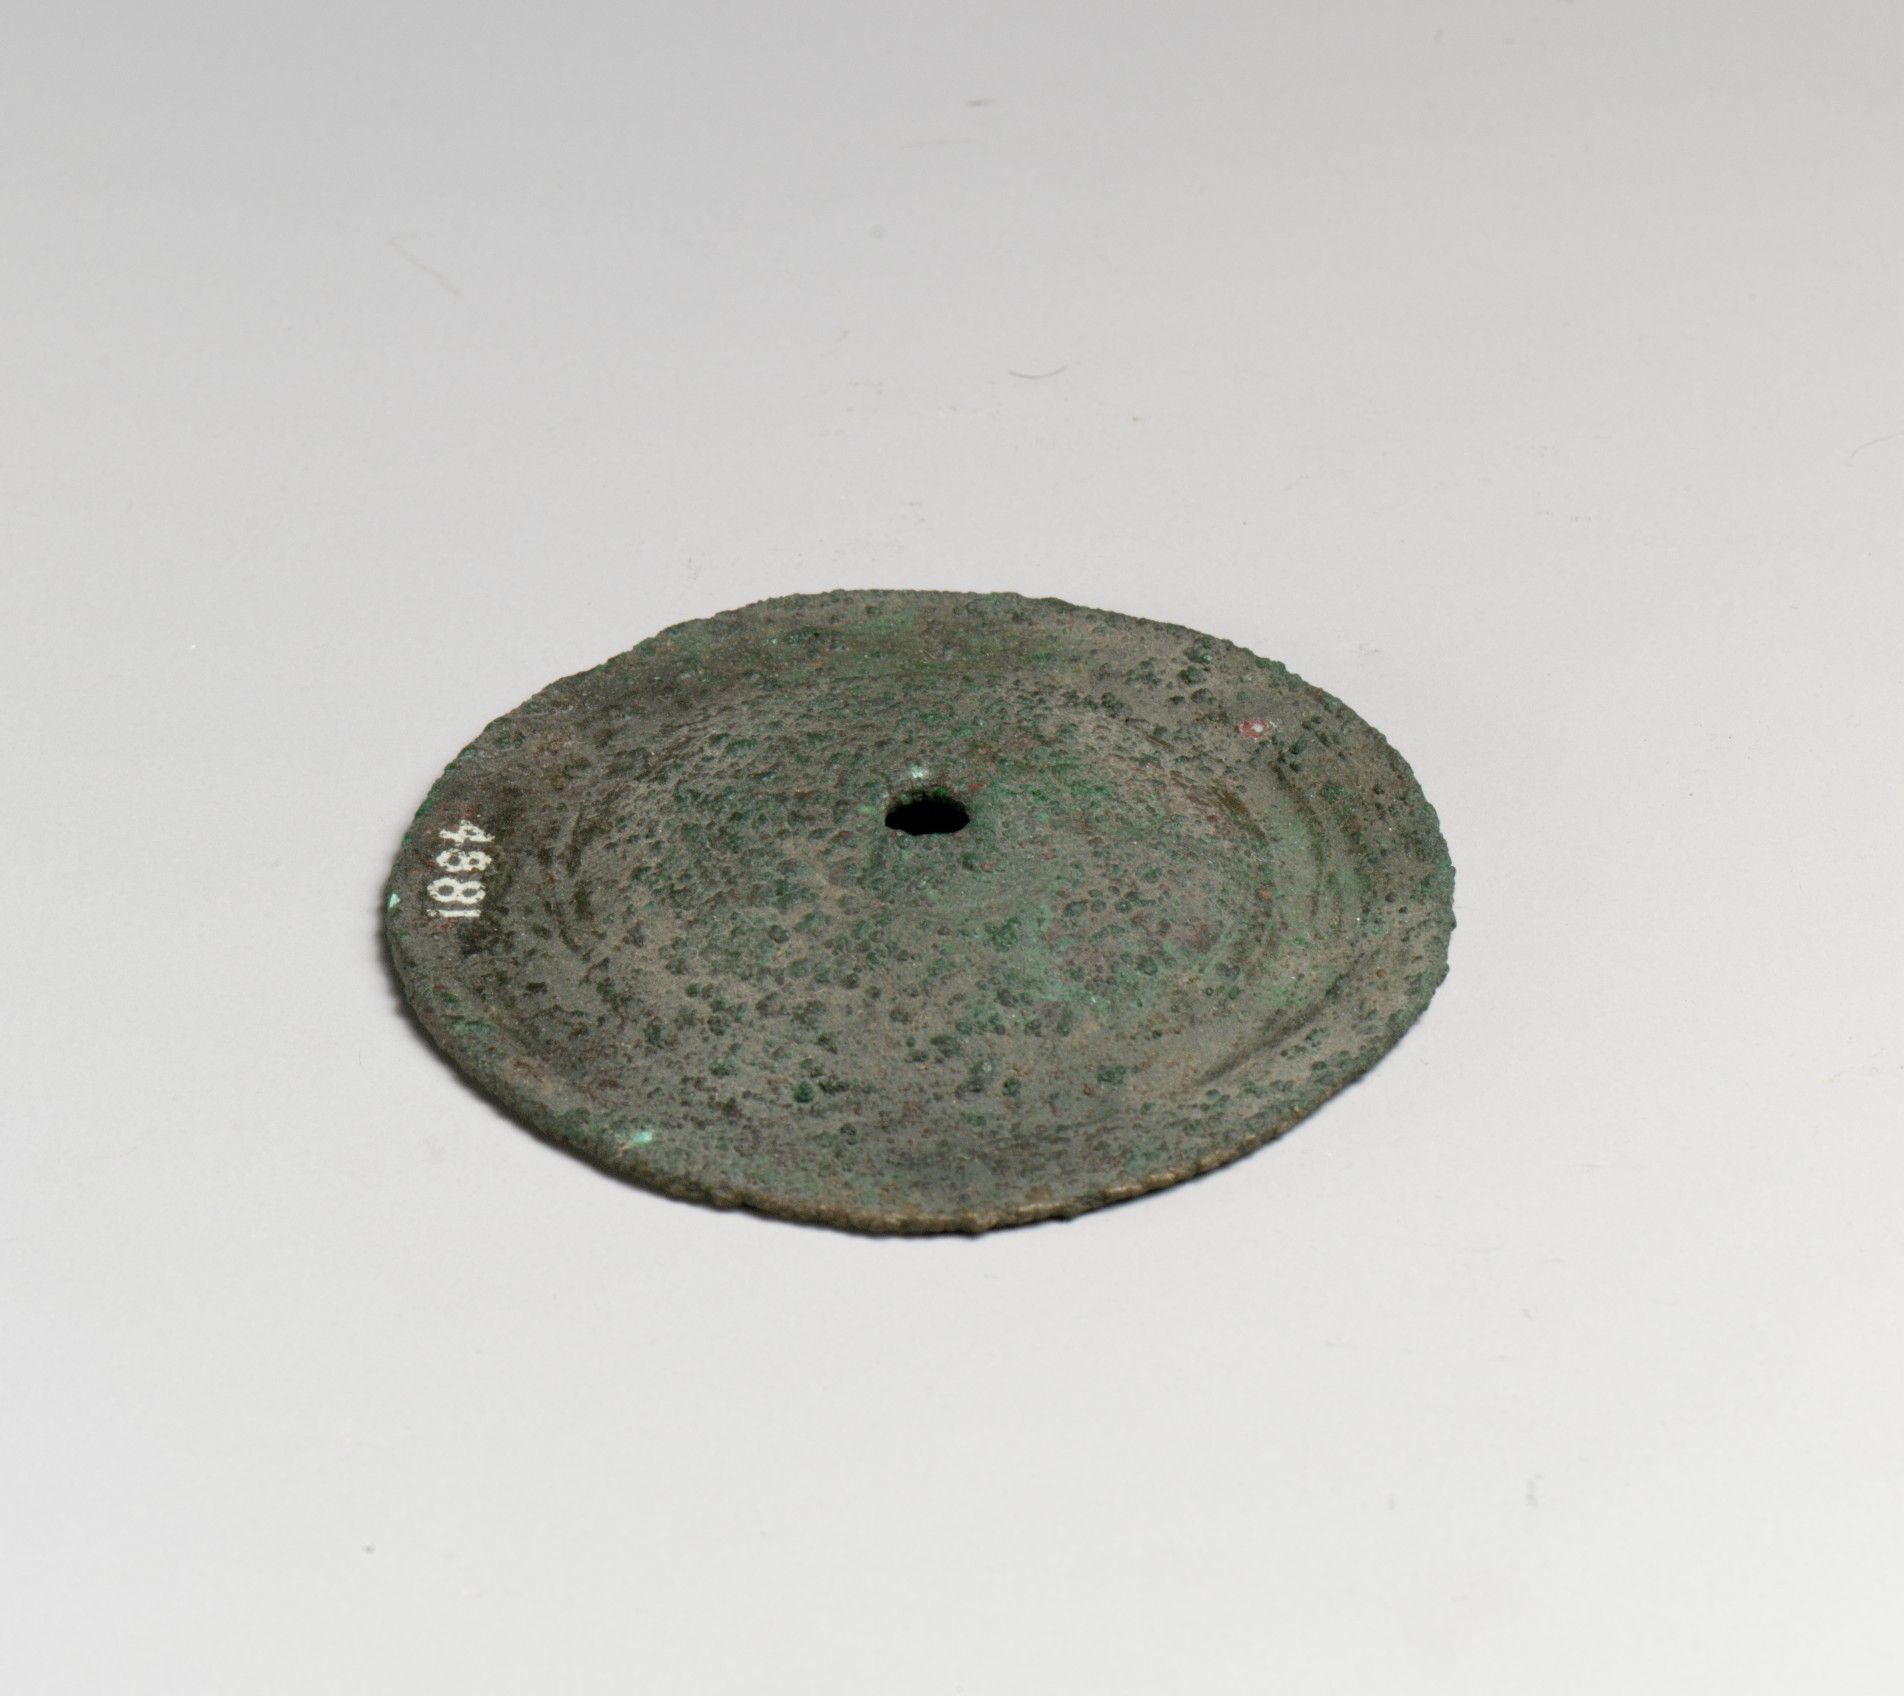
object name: cymbal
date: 7000 BCE-330 CE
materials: bronze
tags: musical instruments